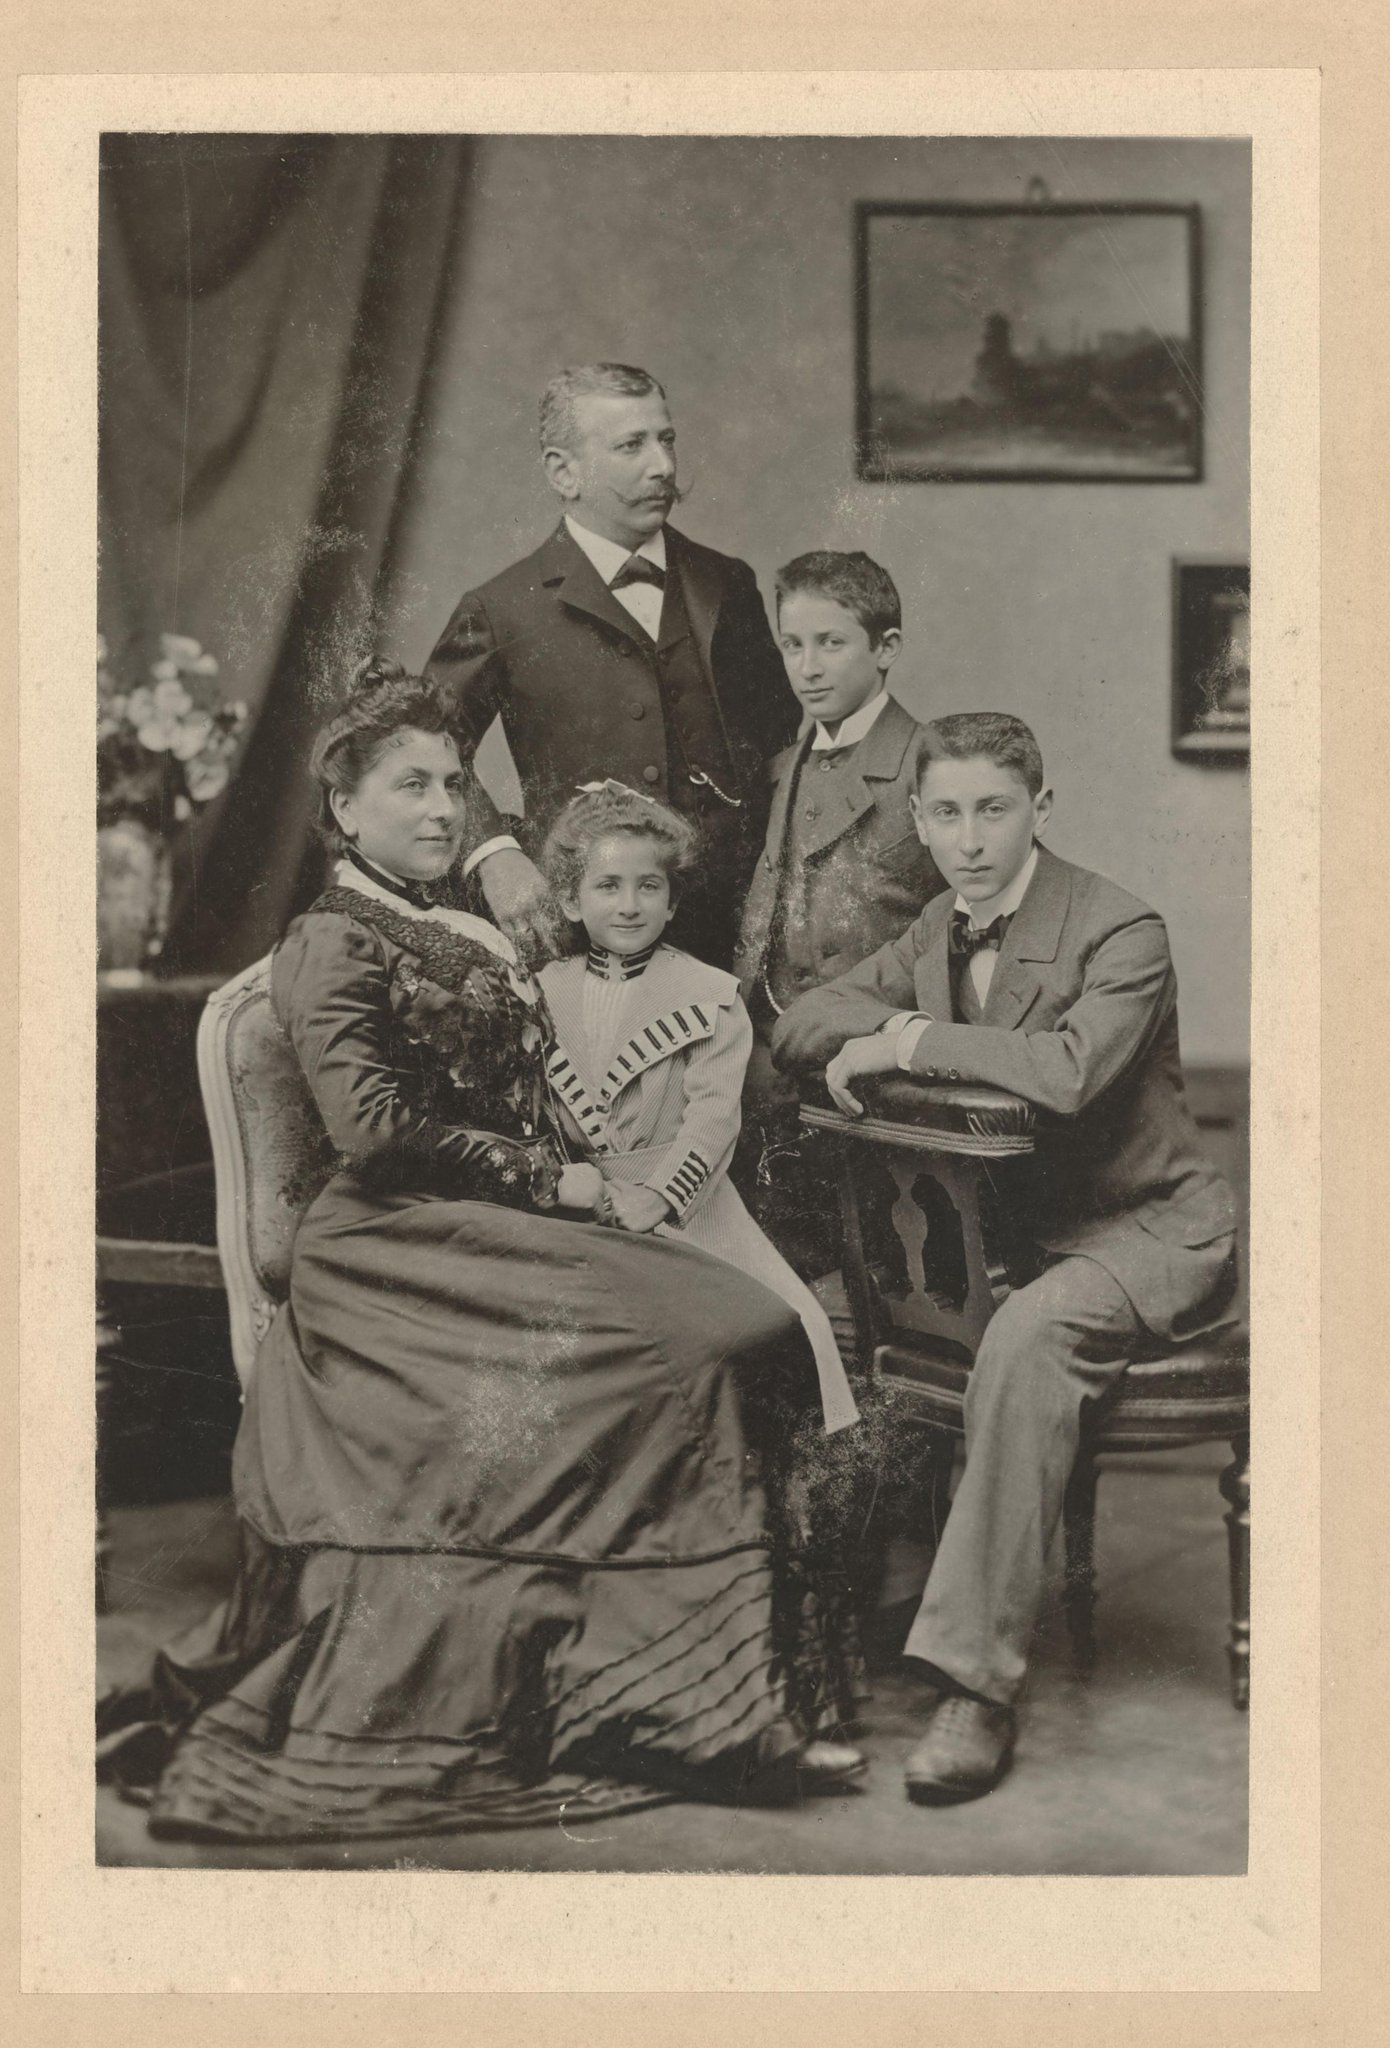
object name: photograph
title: Josefine Moos-Levi, Hermann Moos, Else Wachenheimer-Moos, Willy Moos en Arthur Moos in een familieportret, 1895-1903, Stuttgart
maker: hermann brandseph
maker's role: fotograaf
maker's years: 1826-1915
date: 1895-1905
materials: photographic support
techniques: gelatin silver print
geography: stuttgart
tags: else wachenheimer-moos, willy moos, josefine moos-levi, arthur moos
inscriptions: company name: ‘H. Brandseph Stuttgart 22z95’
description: Josefine Moos-Levi (zittend, links), Hermann Moos (staand, achter), Else Wachenheimer-Moos (staand, midden), Willy Moos (staand, rechts) en Arthur Moos (zittend, rechts) in een familieportret, Stuttgart.